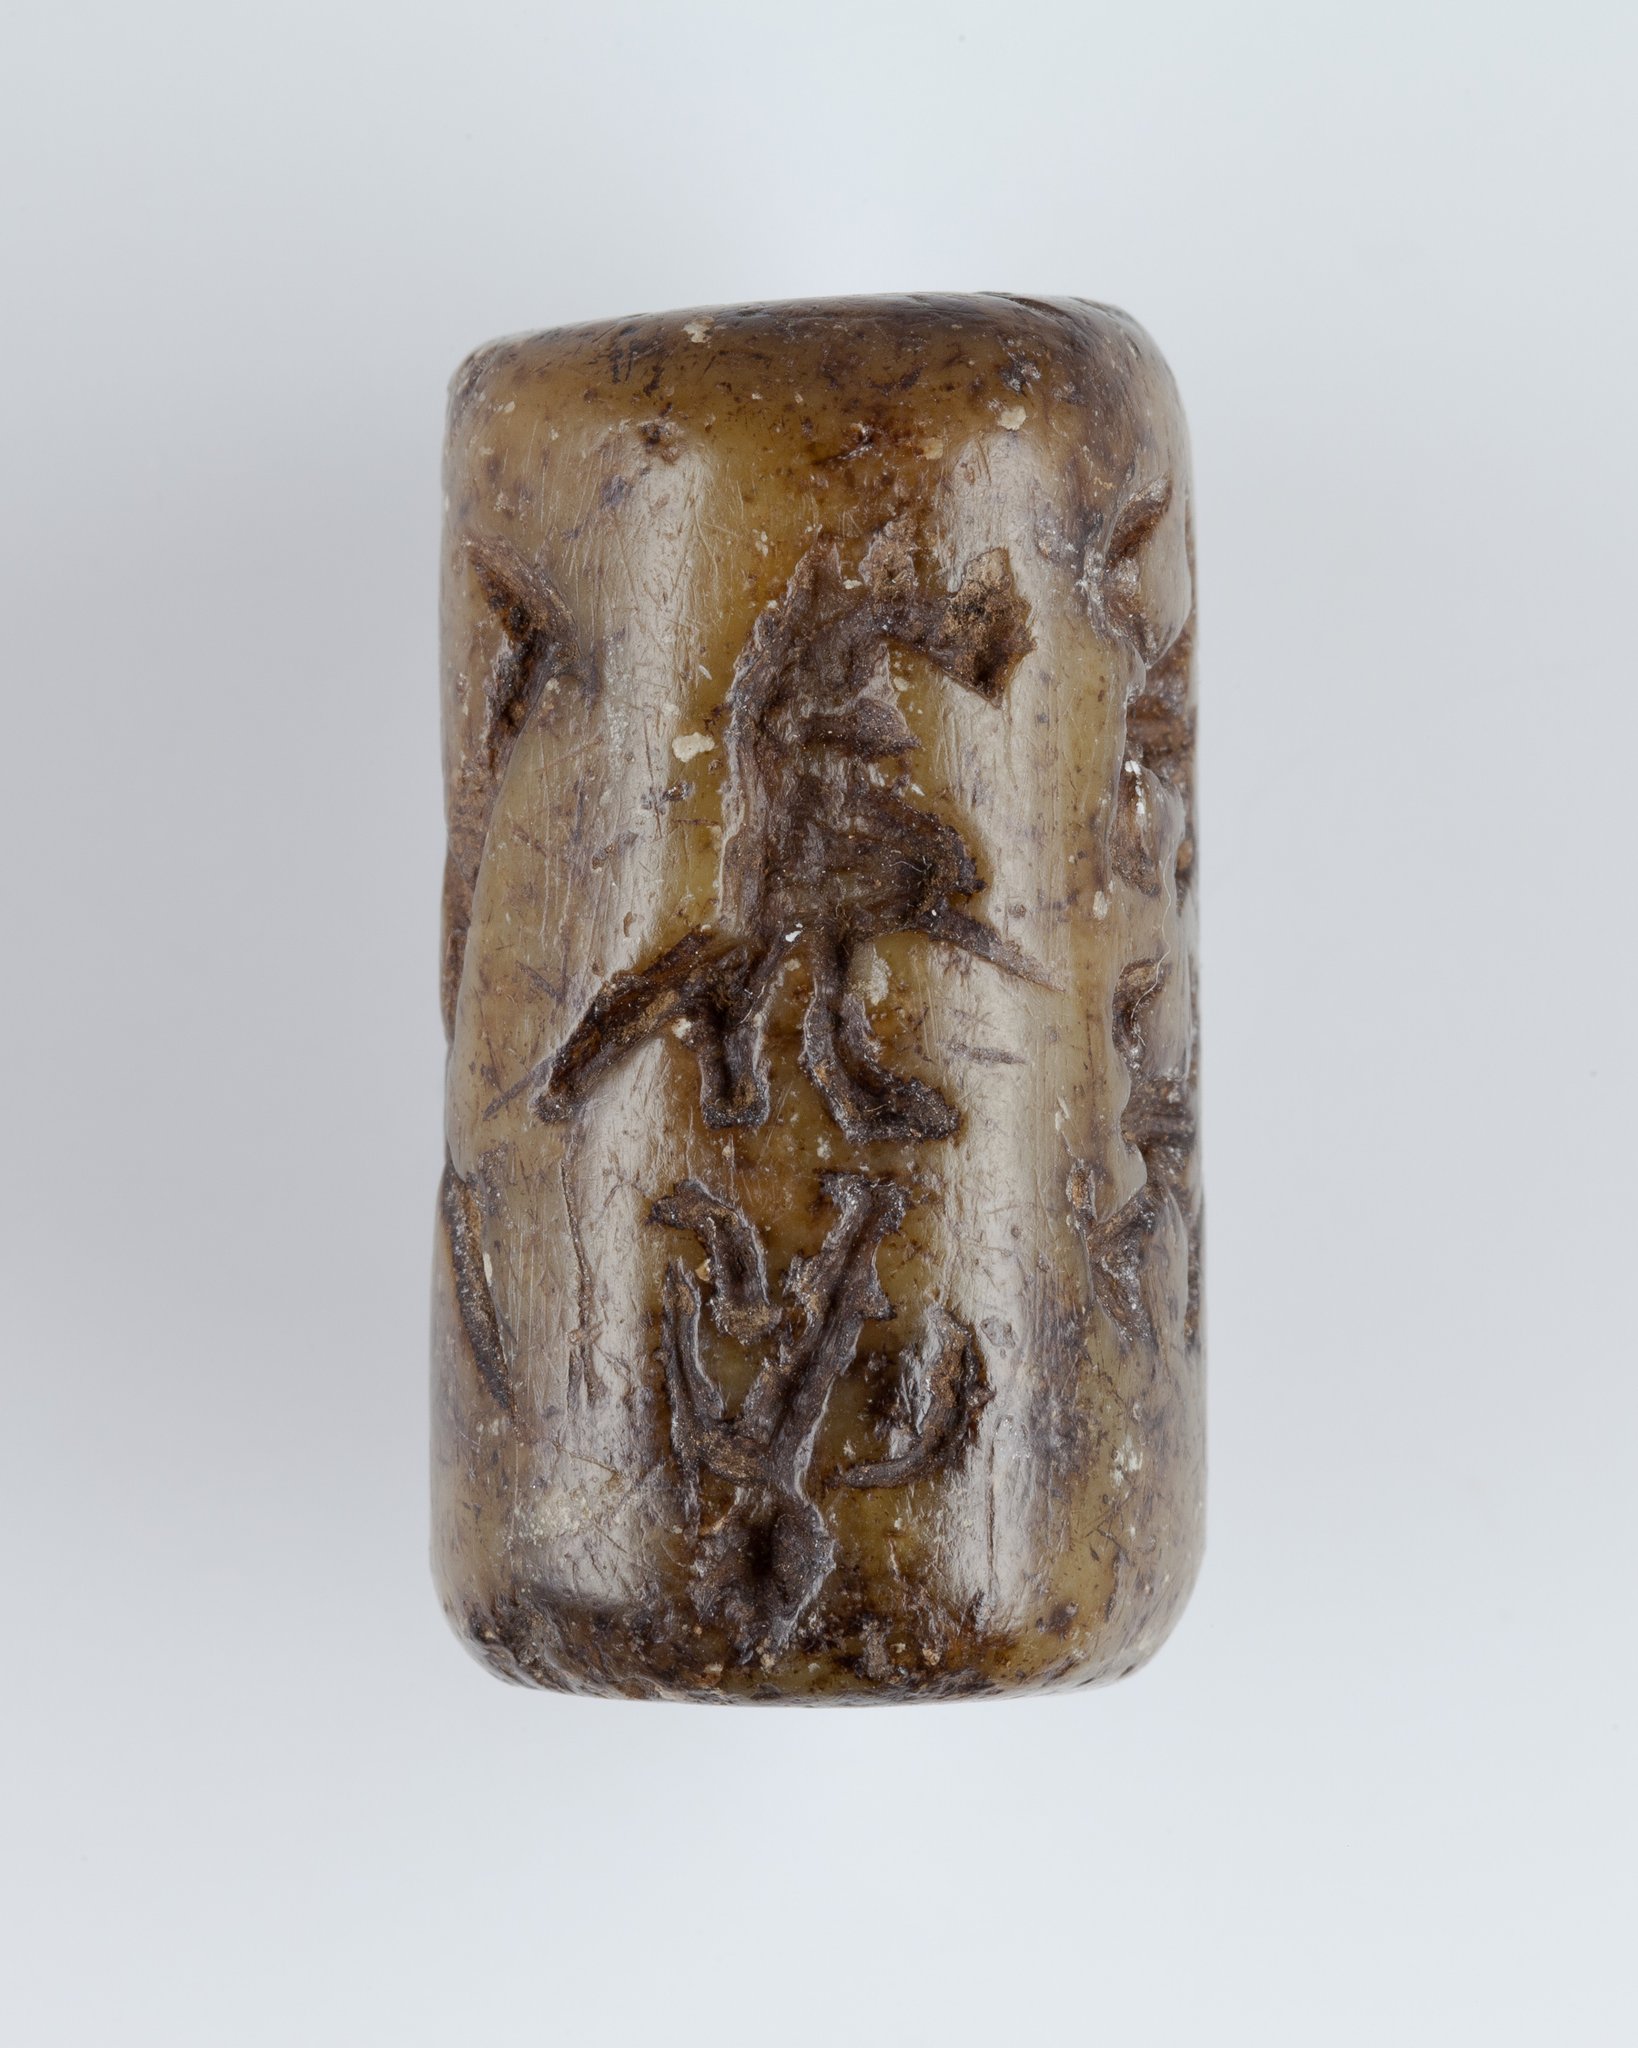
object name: cylinder seal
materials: stone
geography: egypt